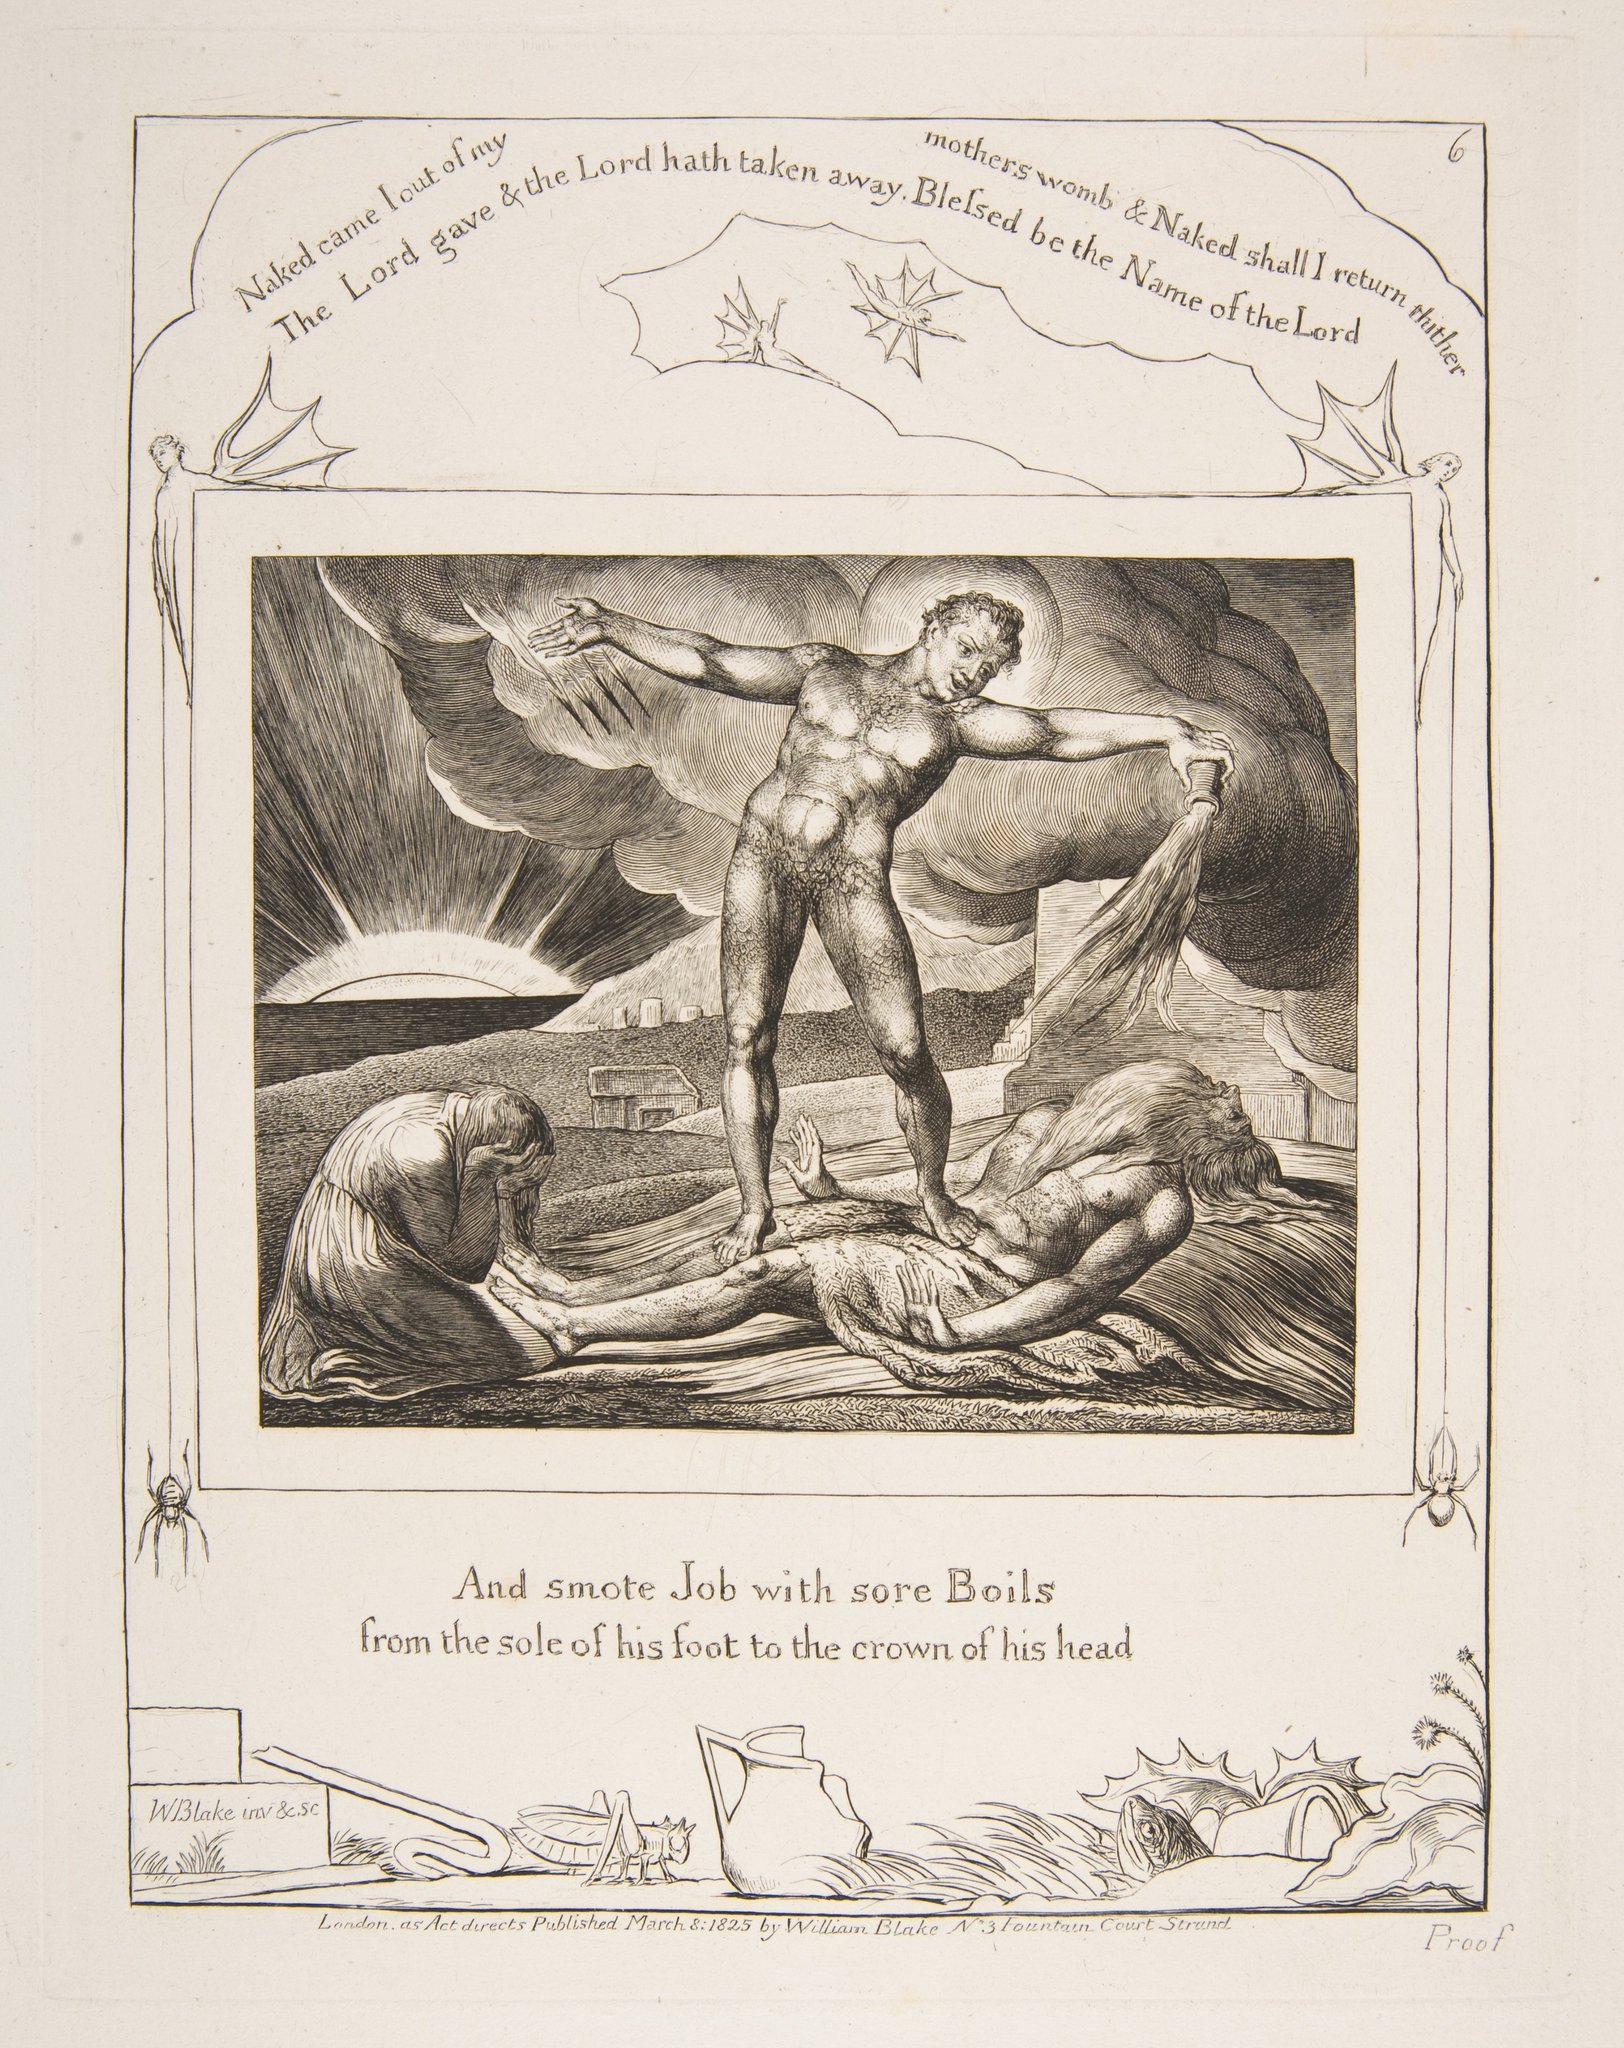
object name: print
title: Satan Smiting Job with Boils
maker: william blake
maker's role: artist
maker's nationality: british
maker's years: 1757-1827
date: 1825-1826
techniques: engraving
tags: men,women,devil